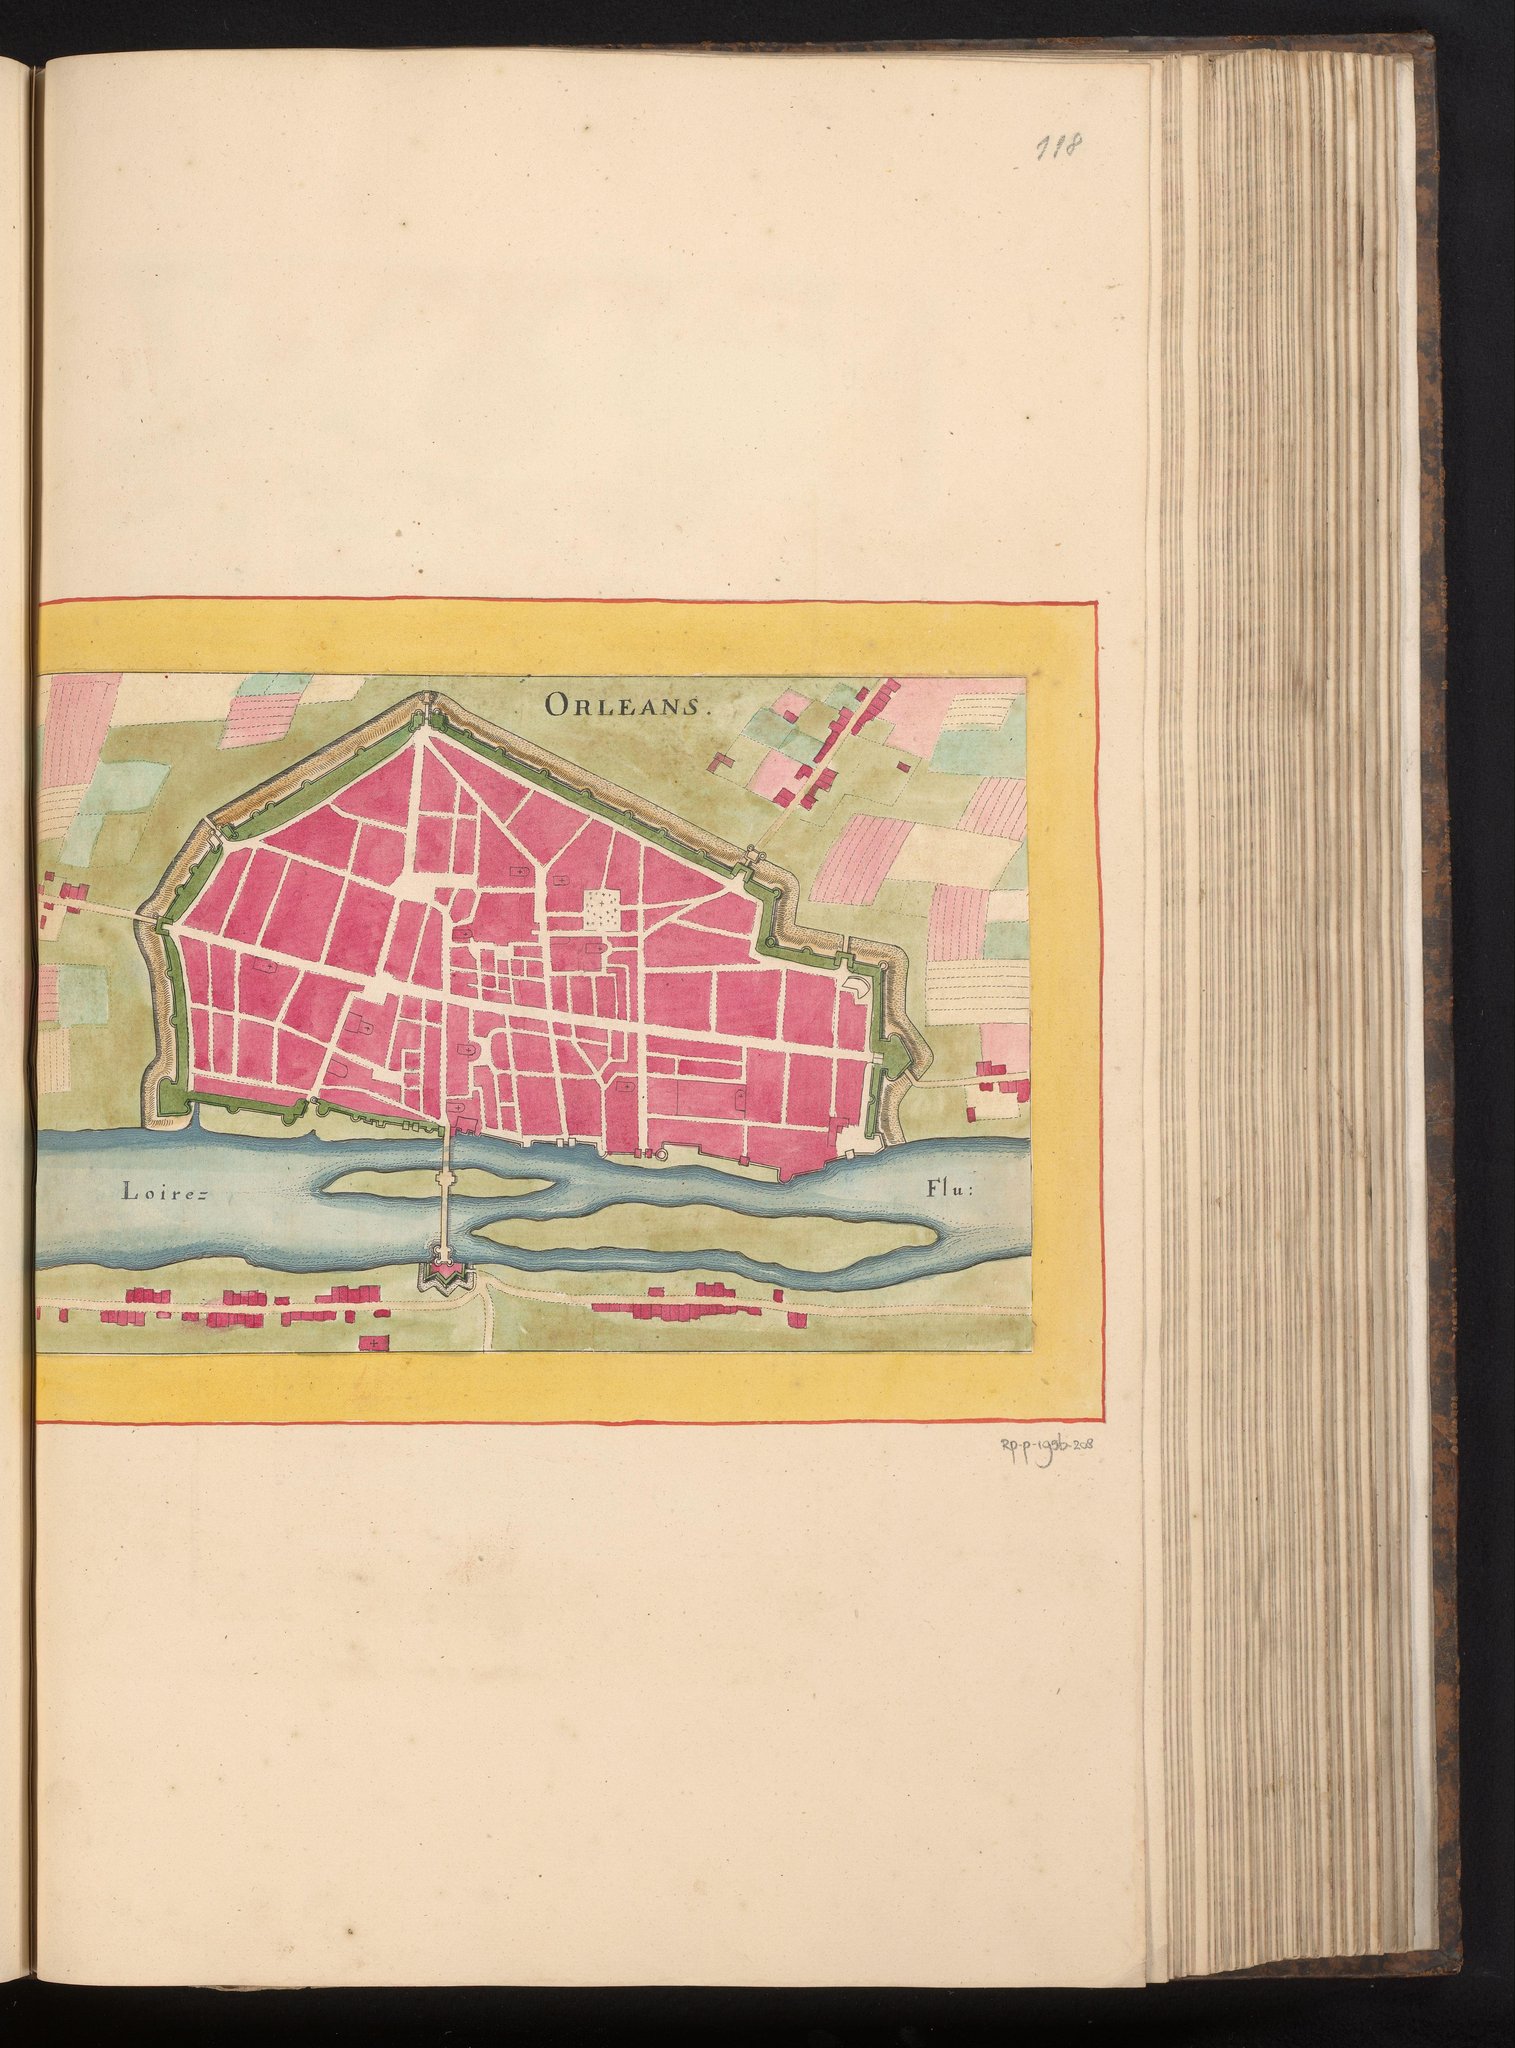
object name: album leaf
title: Orleans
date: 1657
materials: paper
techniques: engraving, etching, hand coloring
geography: the hague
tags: maps of cities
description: Prent uit: Zeiller, Martin. Topographia Galliae. 13 dln. Frankfurt: Caspar Merian, 1657, dl. 7, na p. 44.